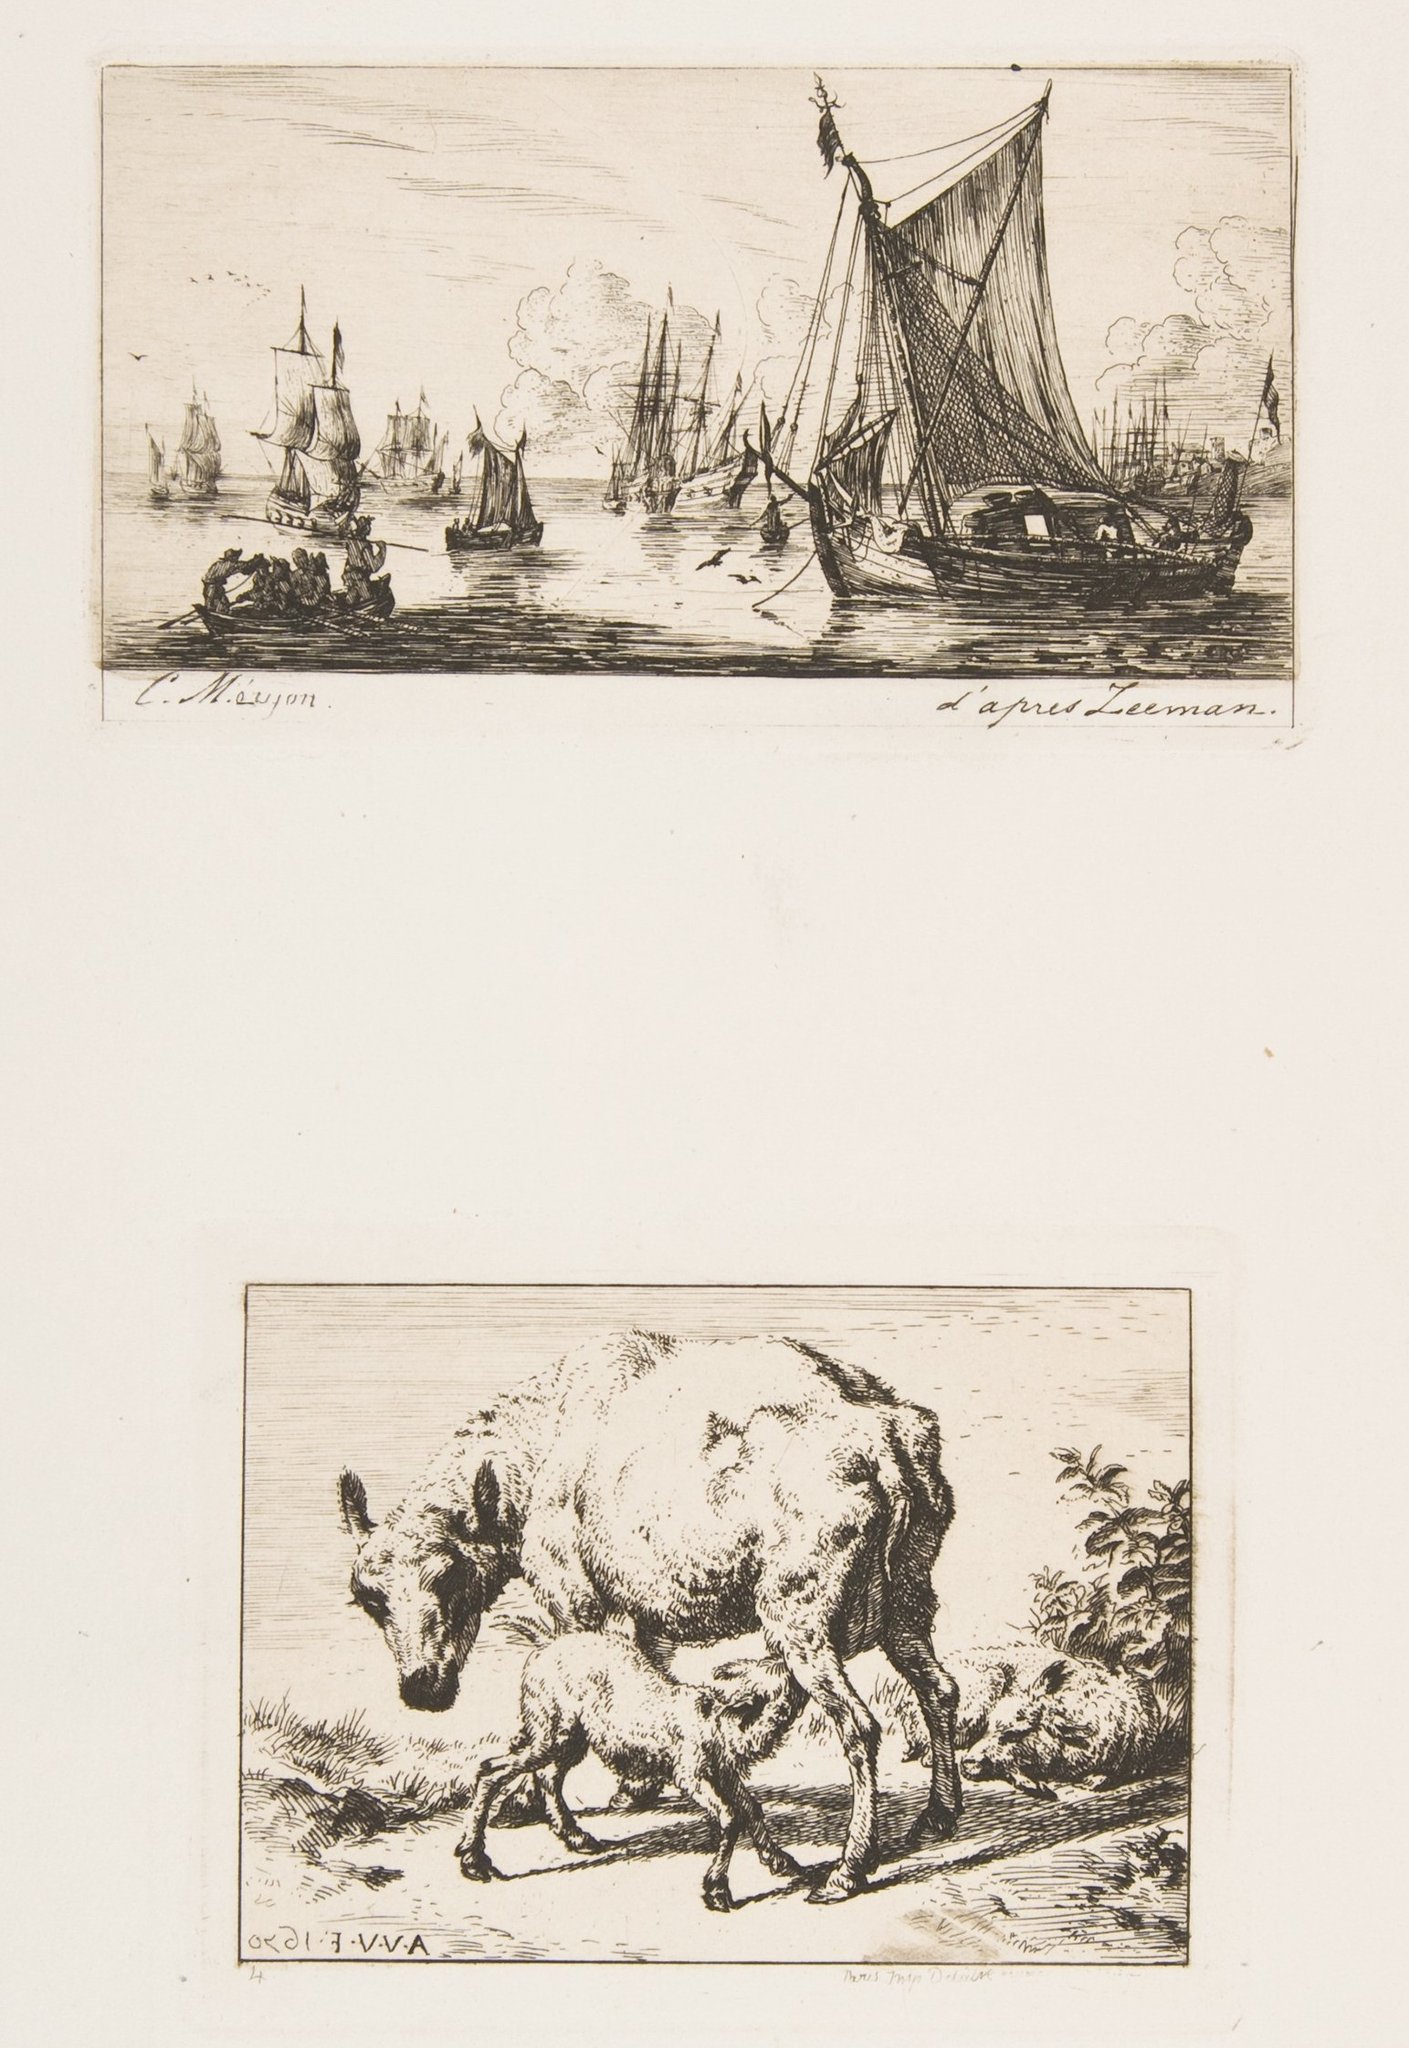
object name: print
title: South Sea Fishers; Ewe with Two Lambs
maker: charles meryon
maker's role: artist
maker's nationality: french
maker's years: 1821-1868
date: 1850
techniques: etching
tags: lambs,ships